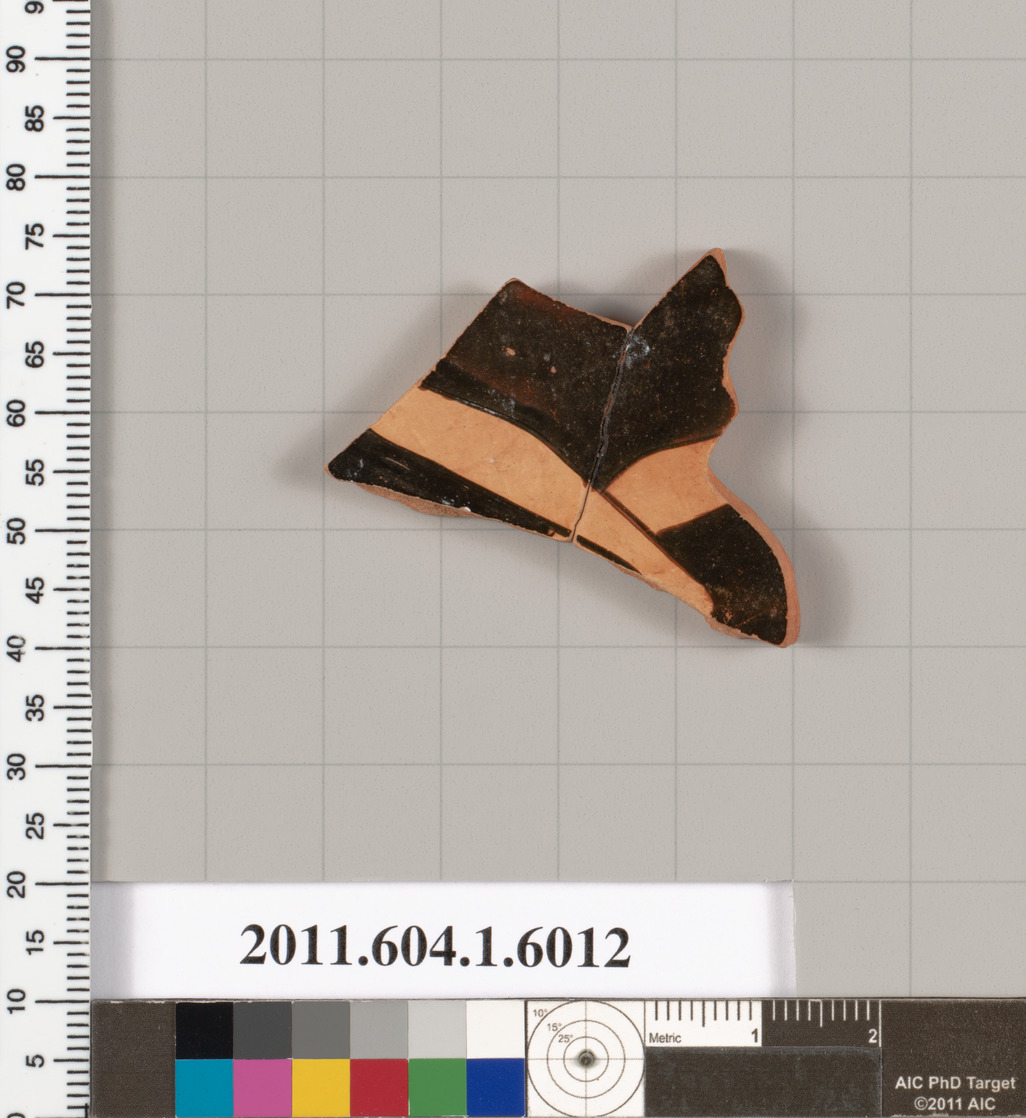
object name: kylix fragment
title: Terracotta fragment of a kylix (drinking cup)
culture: greek, attic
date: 510-500 BCE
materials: terracotta